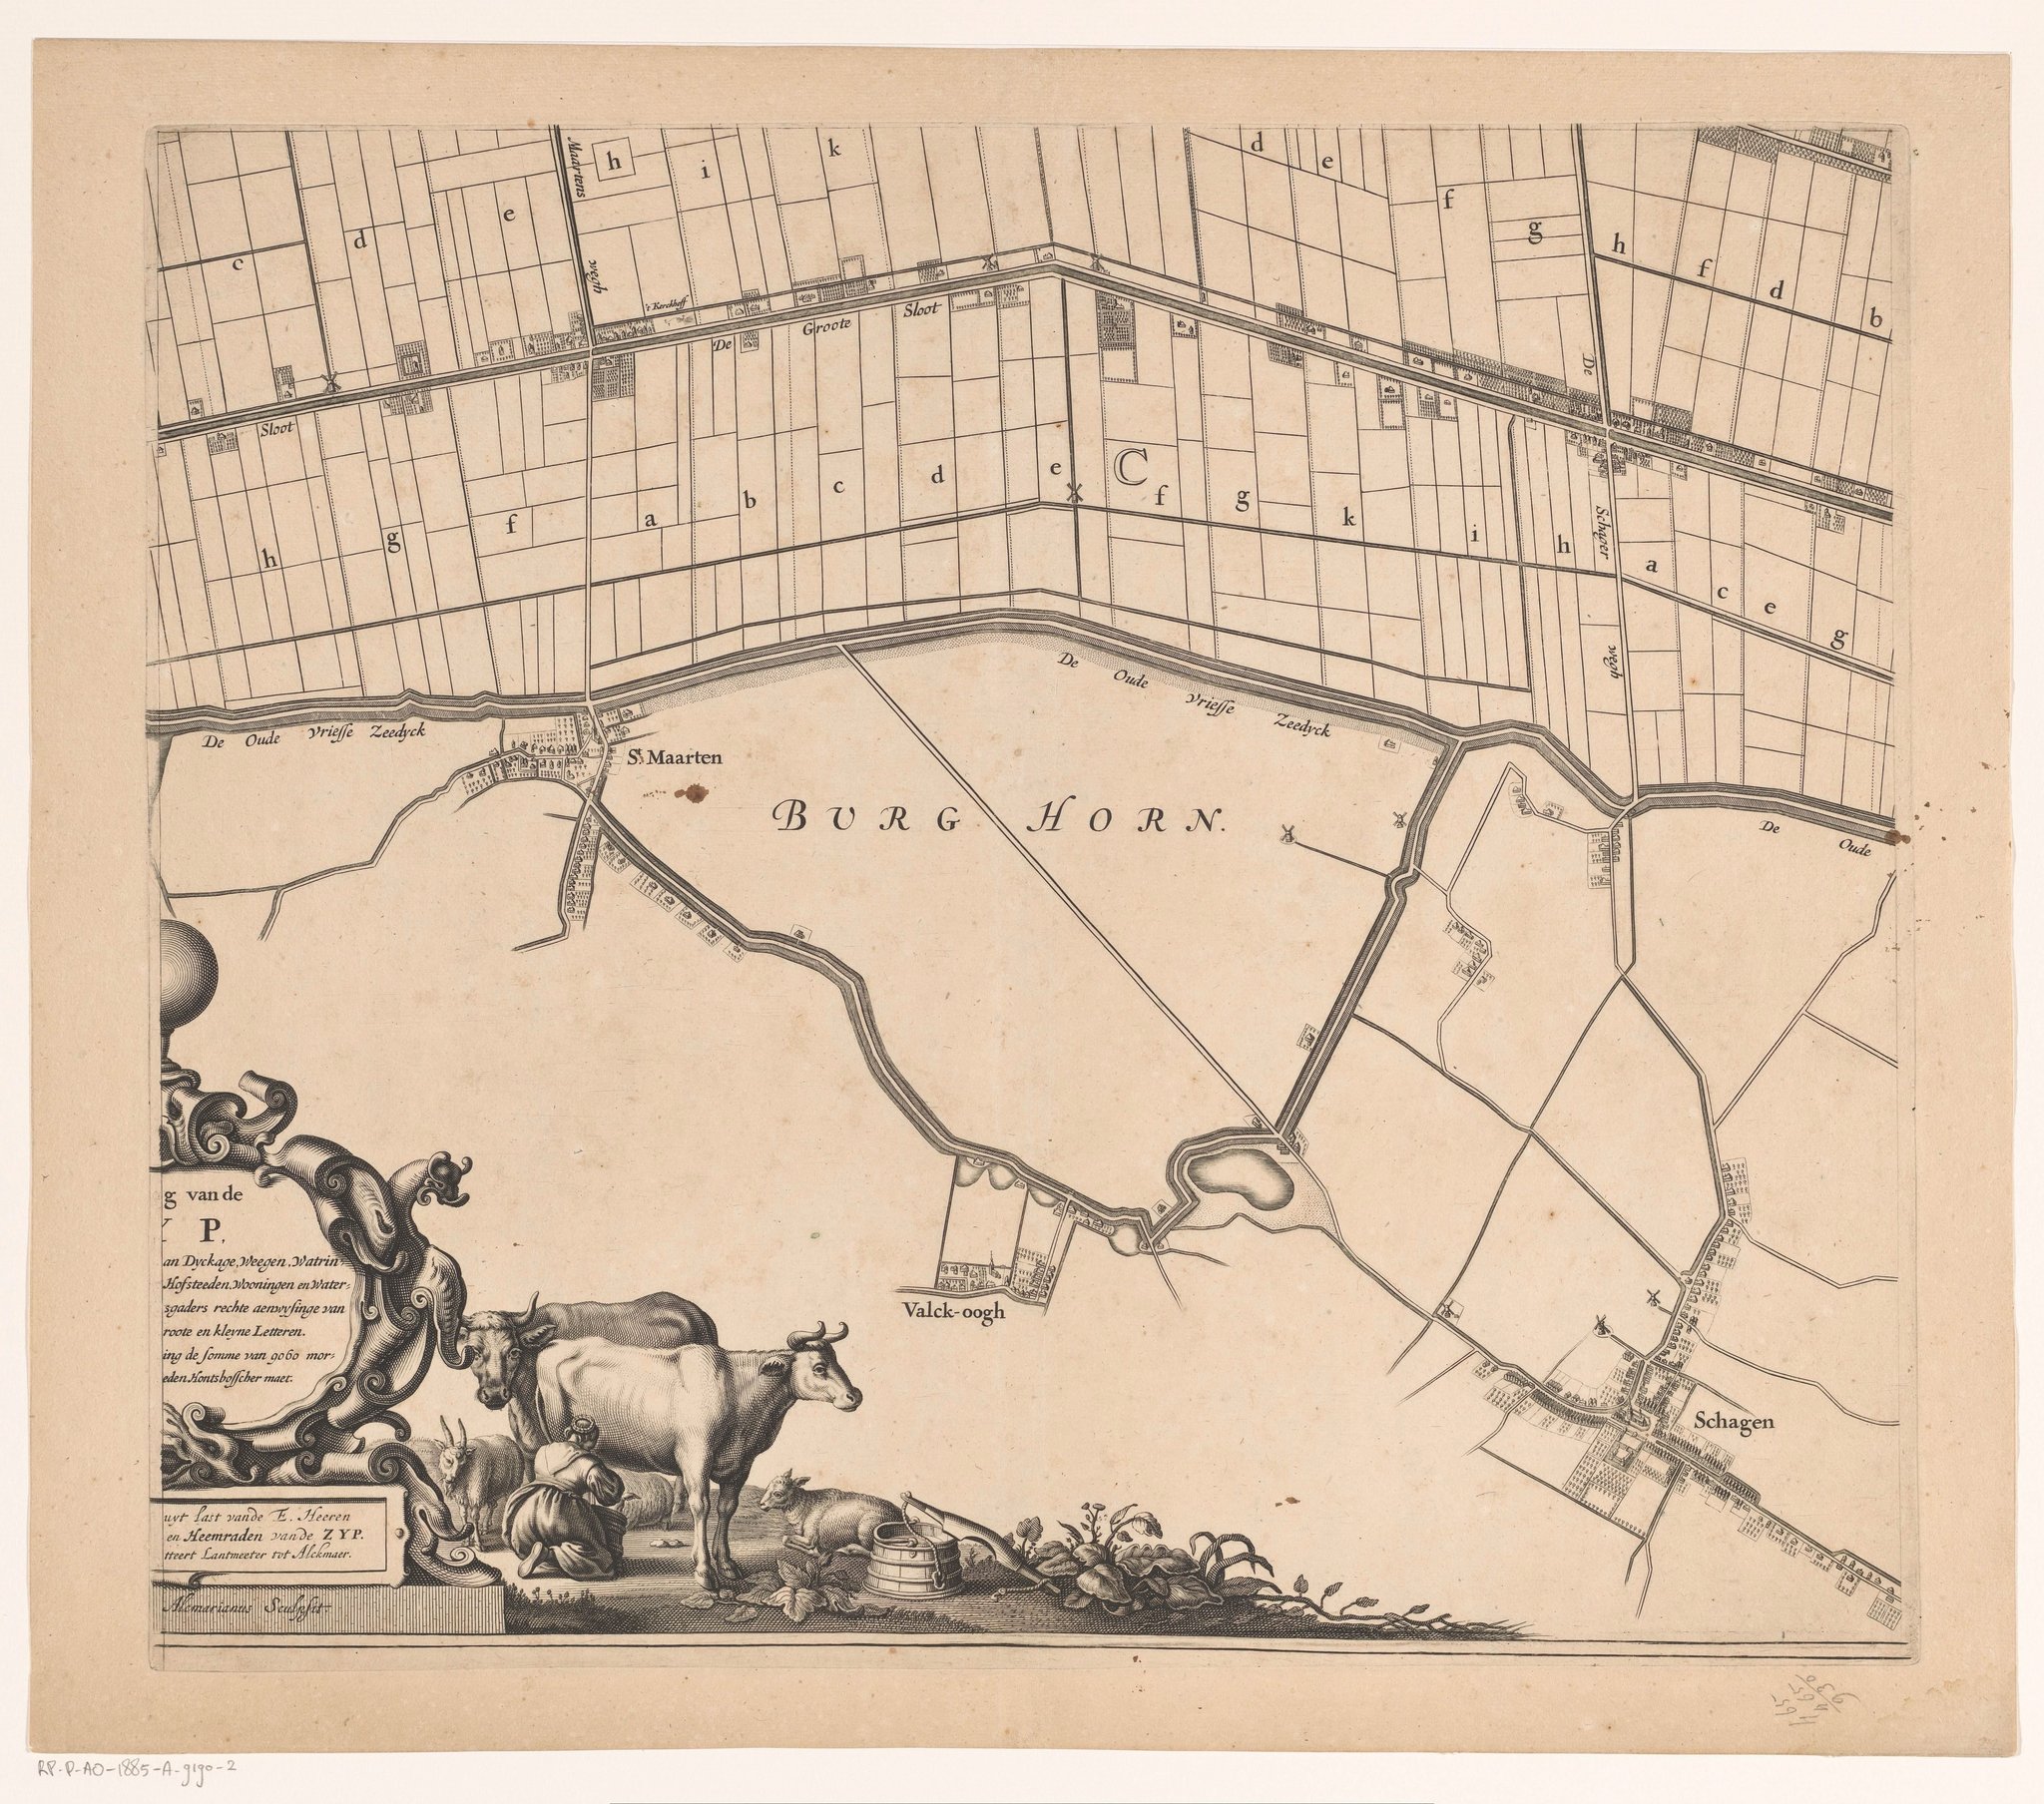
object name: print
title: Kaart van de Zijpe- en Hazepolder (deel midden onder)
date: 1665-1760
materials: paper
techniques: engraving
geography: gouda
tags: maps of separate countries or regions, cattle, farmers, polder, reclaimed land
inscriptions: collector's mark: Lugt 2228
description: Deel (midden onder) van een kaart van de Zijpepolder.